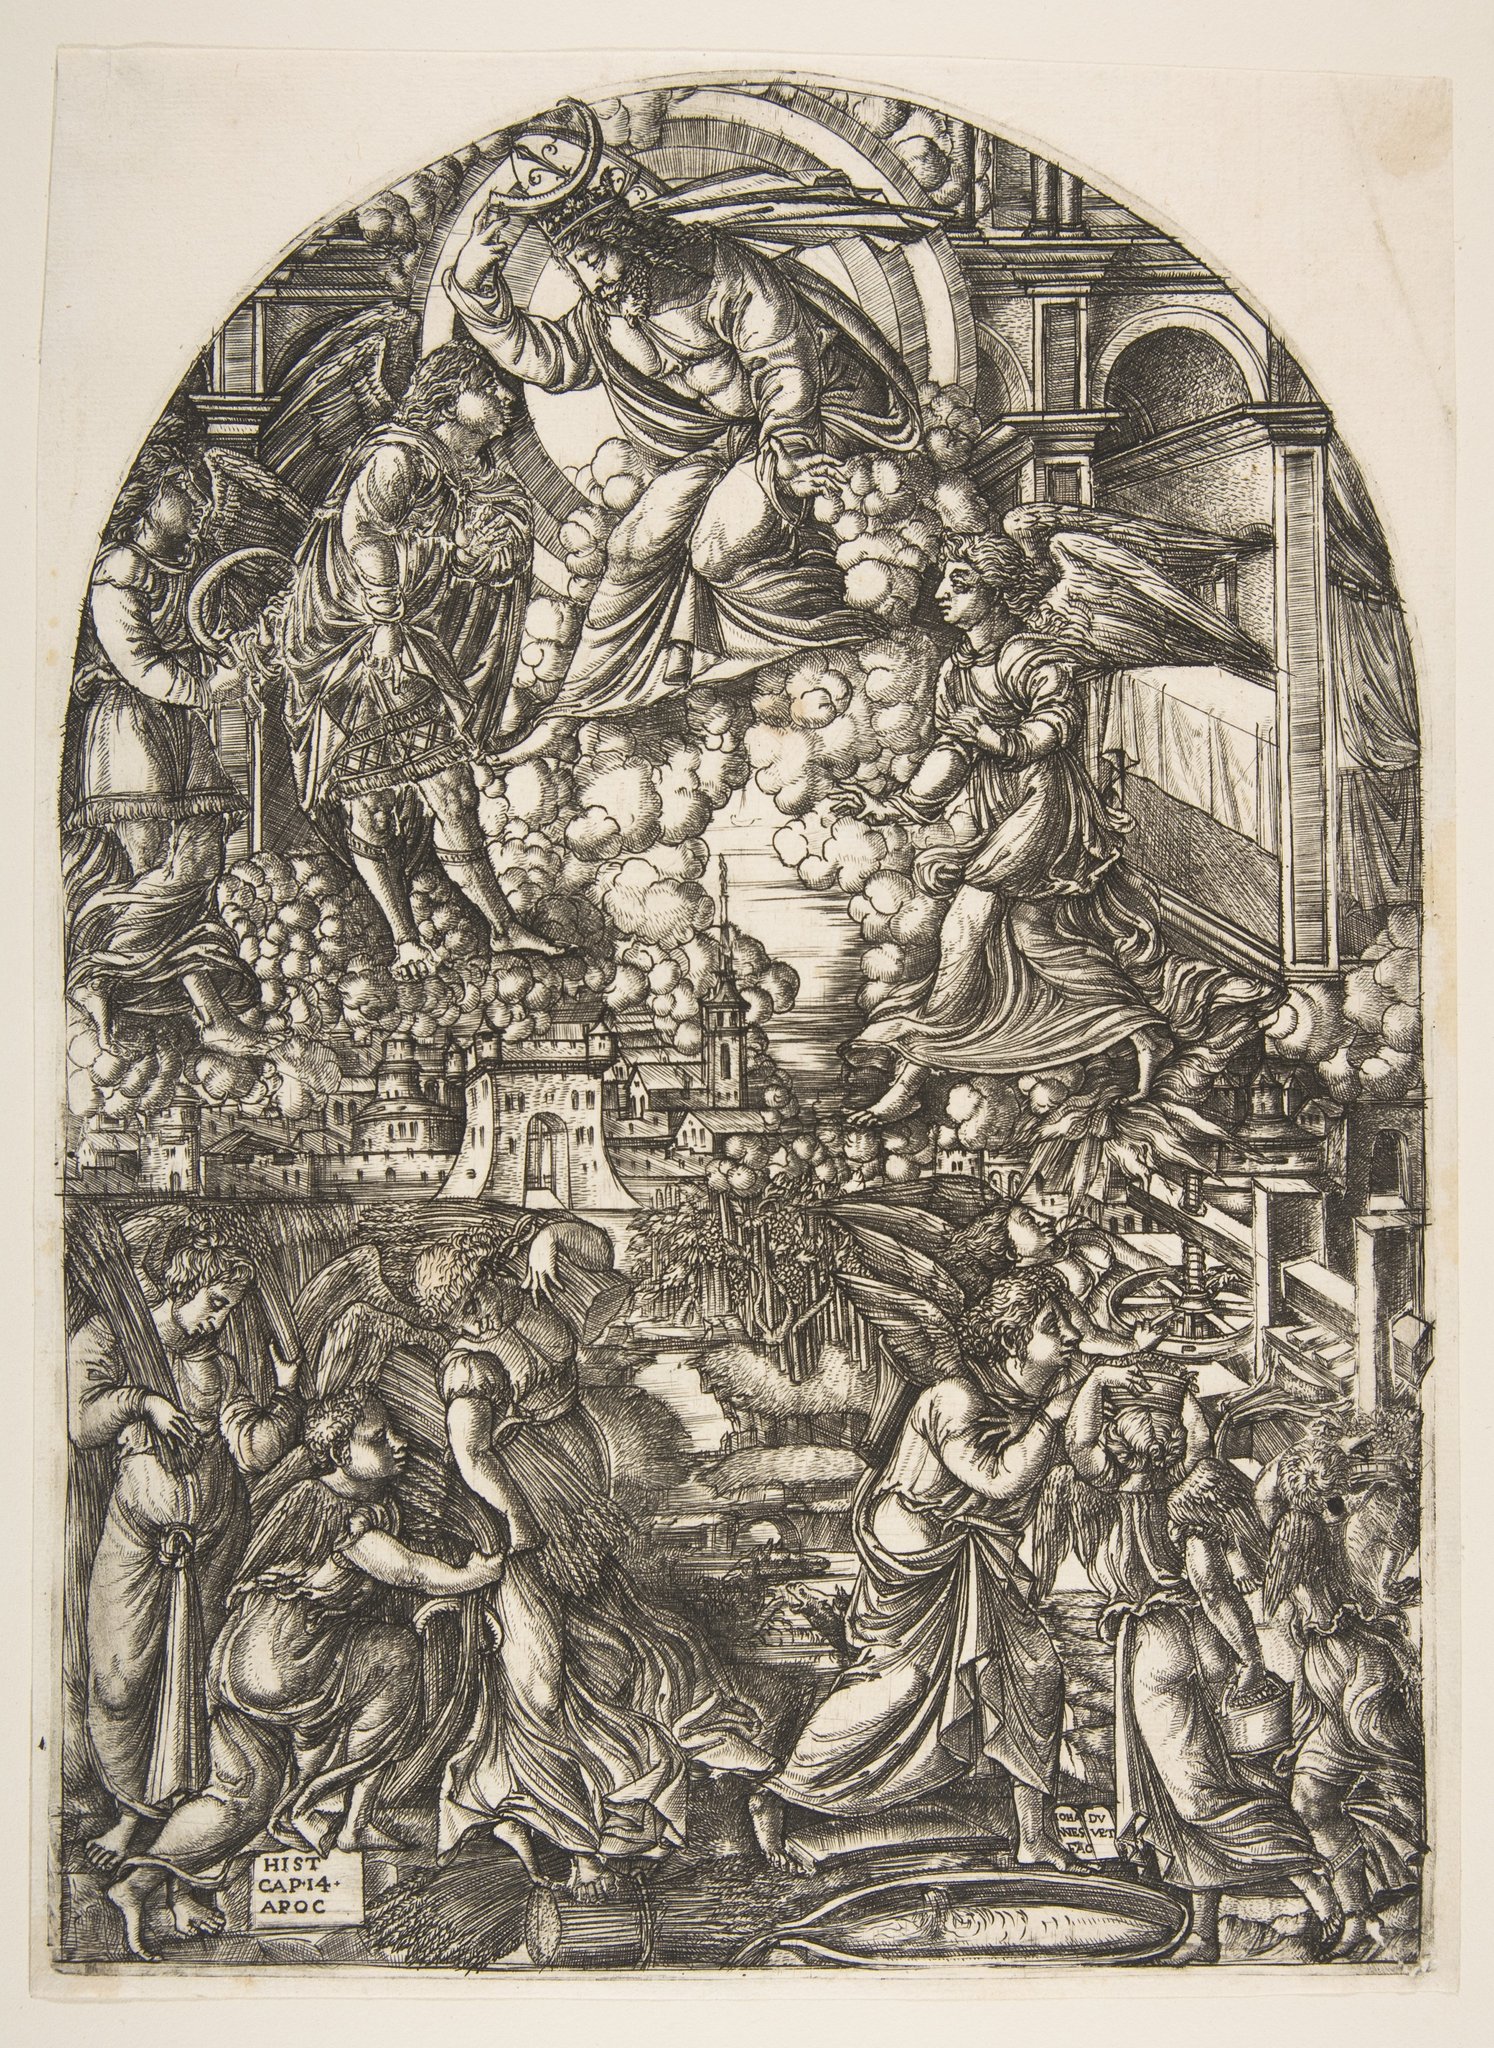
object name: print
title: The Winepress of the Wrath of God, from the Apocalypse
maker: jean duvet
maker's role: artist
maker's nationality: french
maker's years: 1485-1561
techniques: engraving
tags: angels,apocalypse